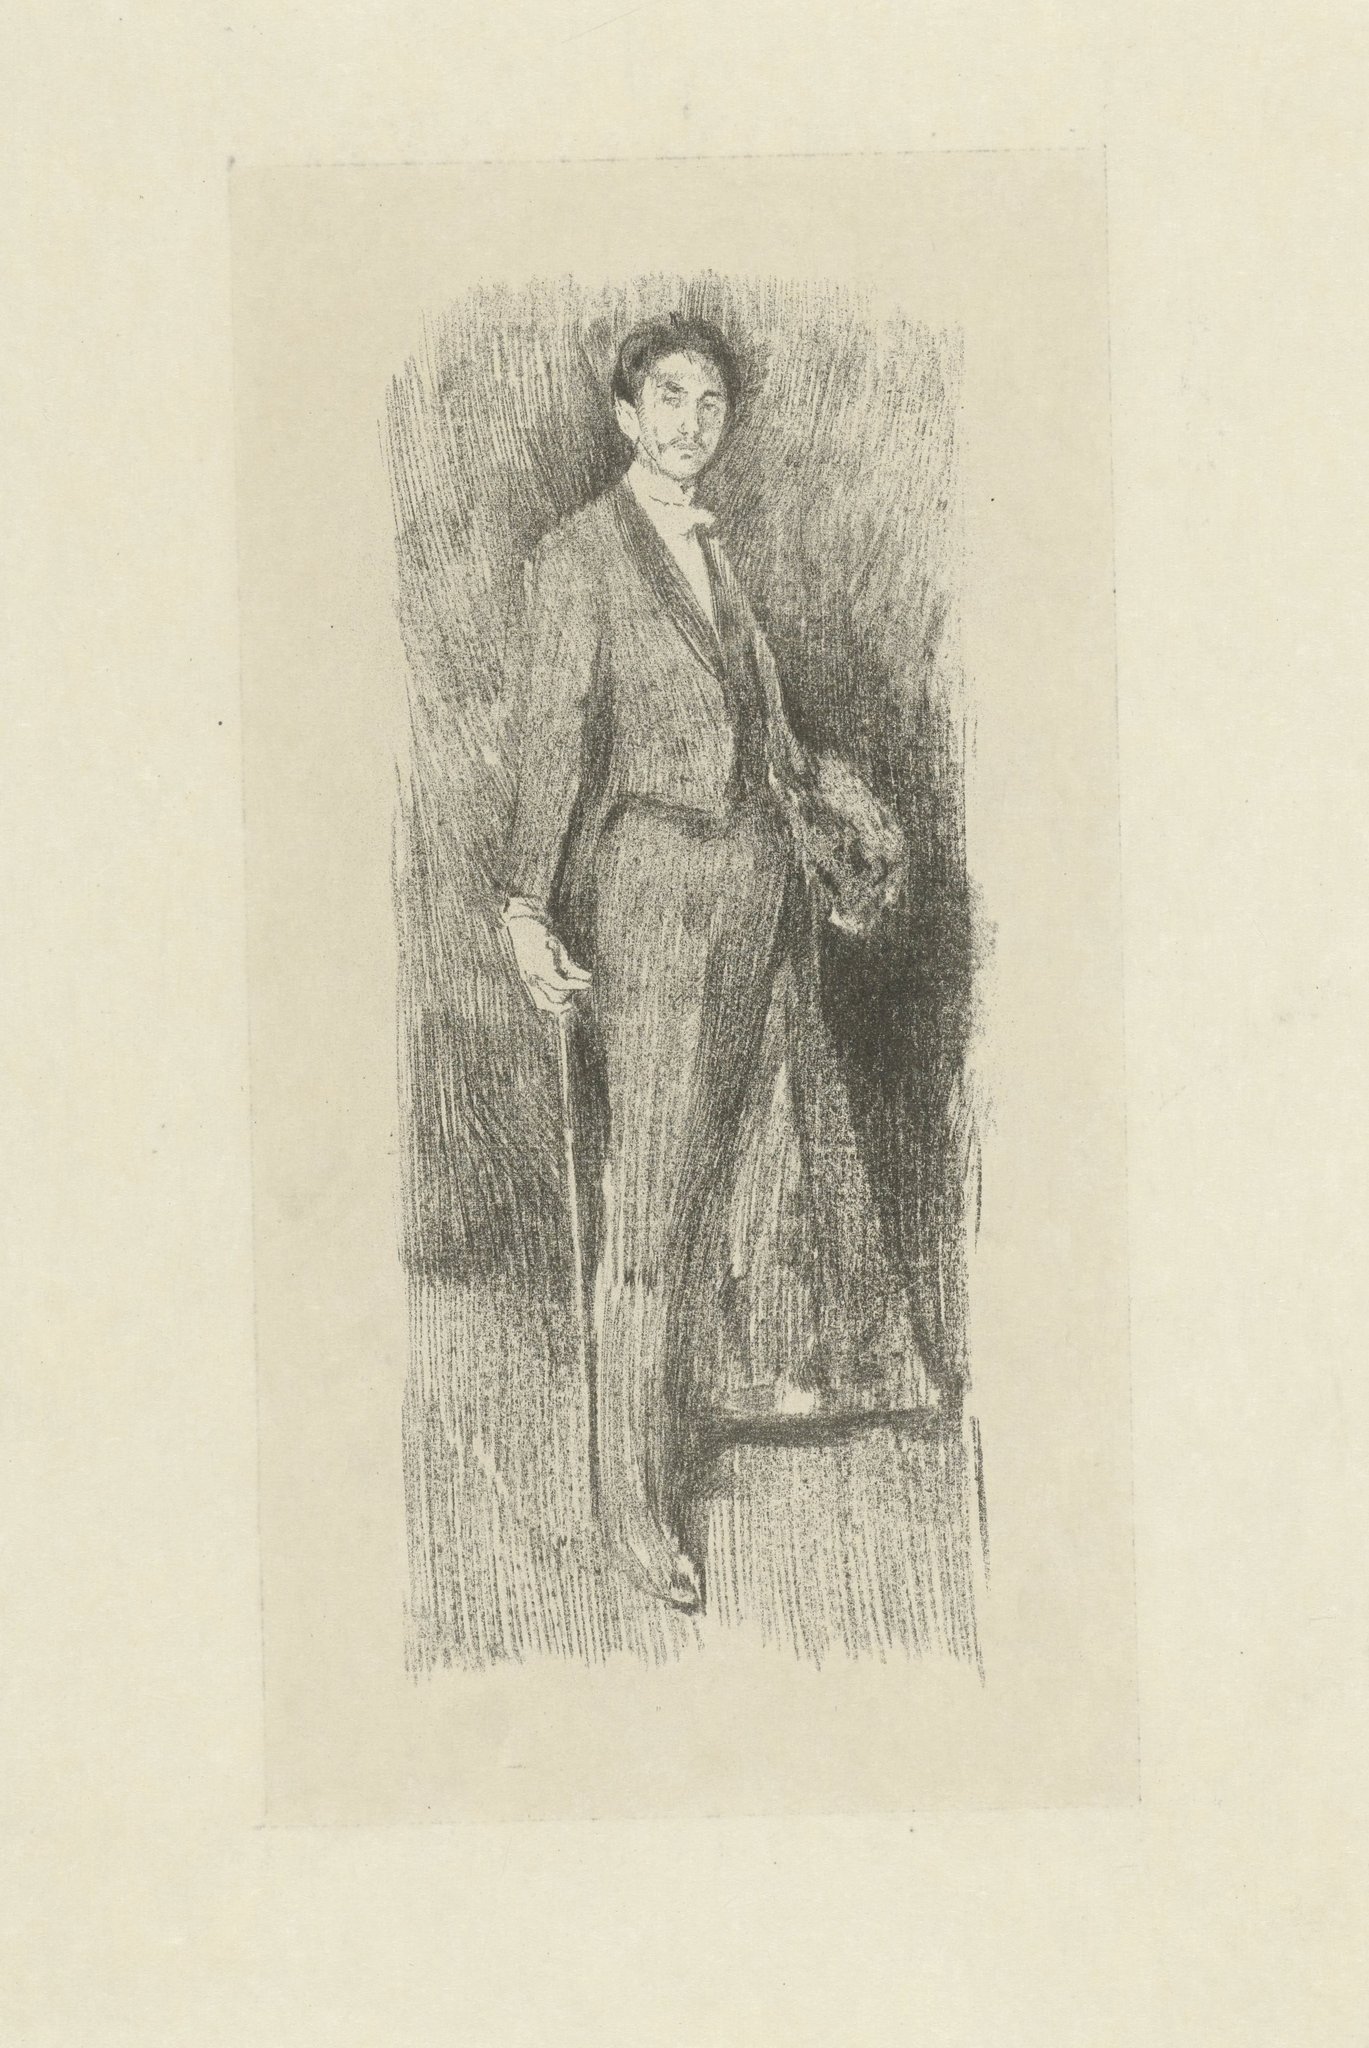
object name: print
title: Count Robert de Montesquiou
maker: james abbott mcneill whistler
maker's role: painter, print maker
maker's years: 1834-1903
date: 1895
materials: paper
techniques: lithograph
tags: paris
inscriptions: collector's mark: Lugt 2228, collector's mark: Lugt 2760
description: Portret van graaf Robert de Montesquion, staand, met een wandelstok in de rechterhand en een bontmantel over zijn linker arm.